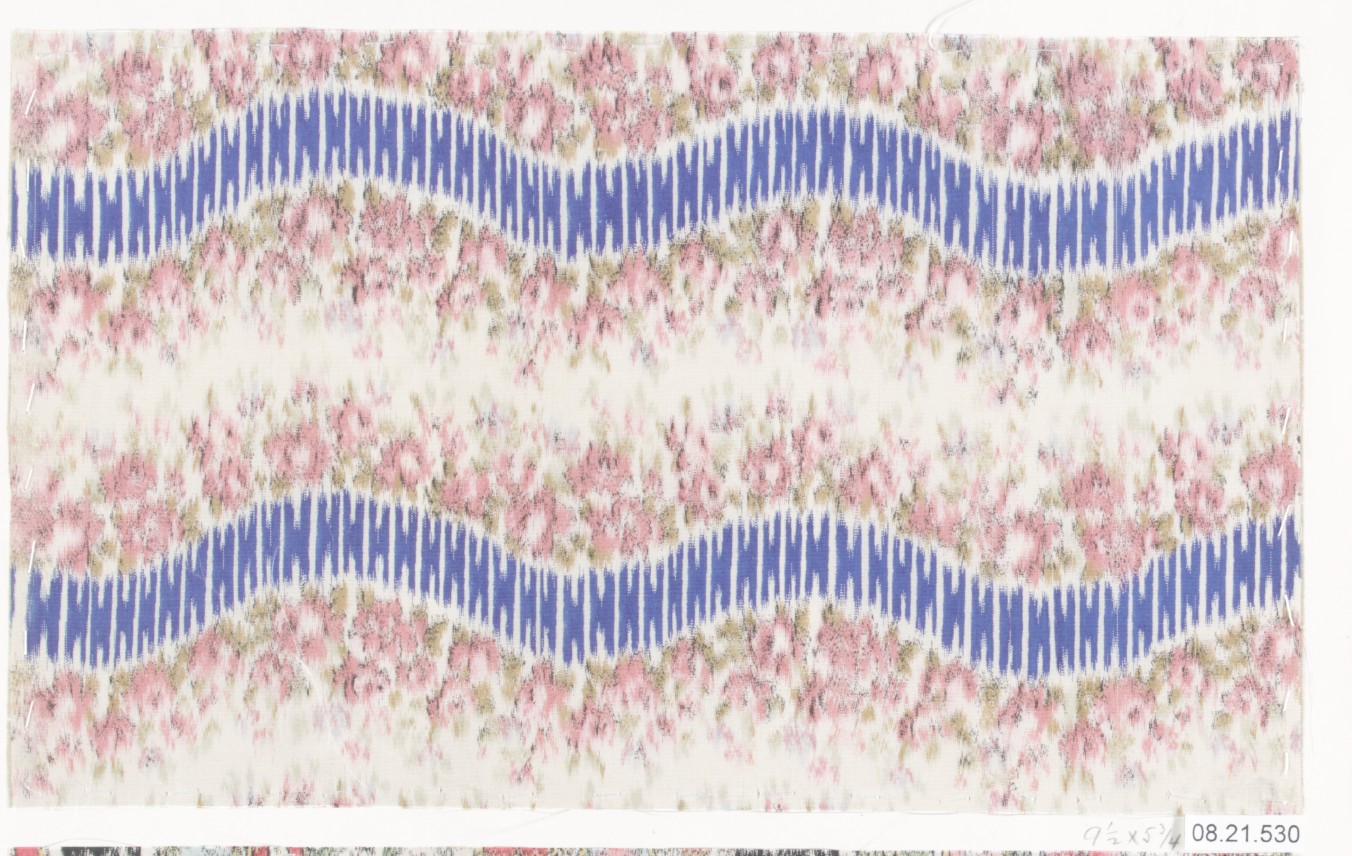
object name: textile sample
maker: Anonymous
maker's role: designer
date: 1900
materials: silk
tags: flowers